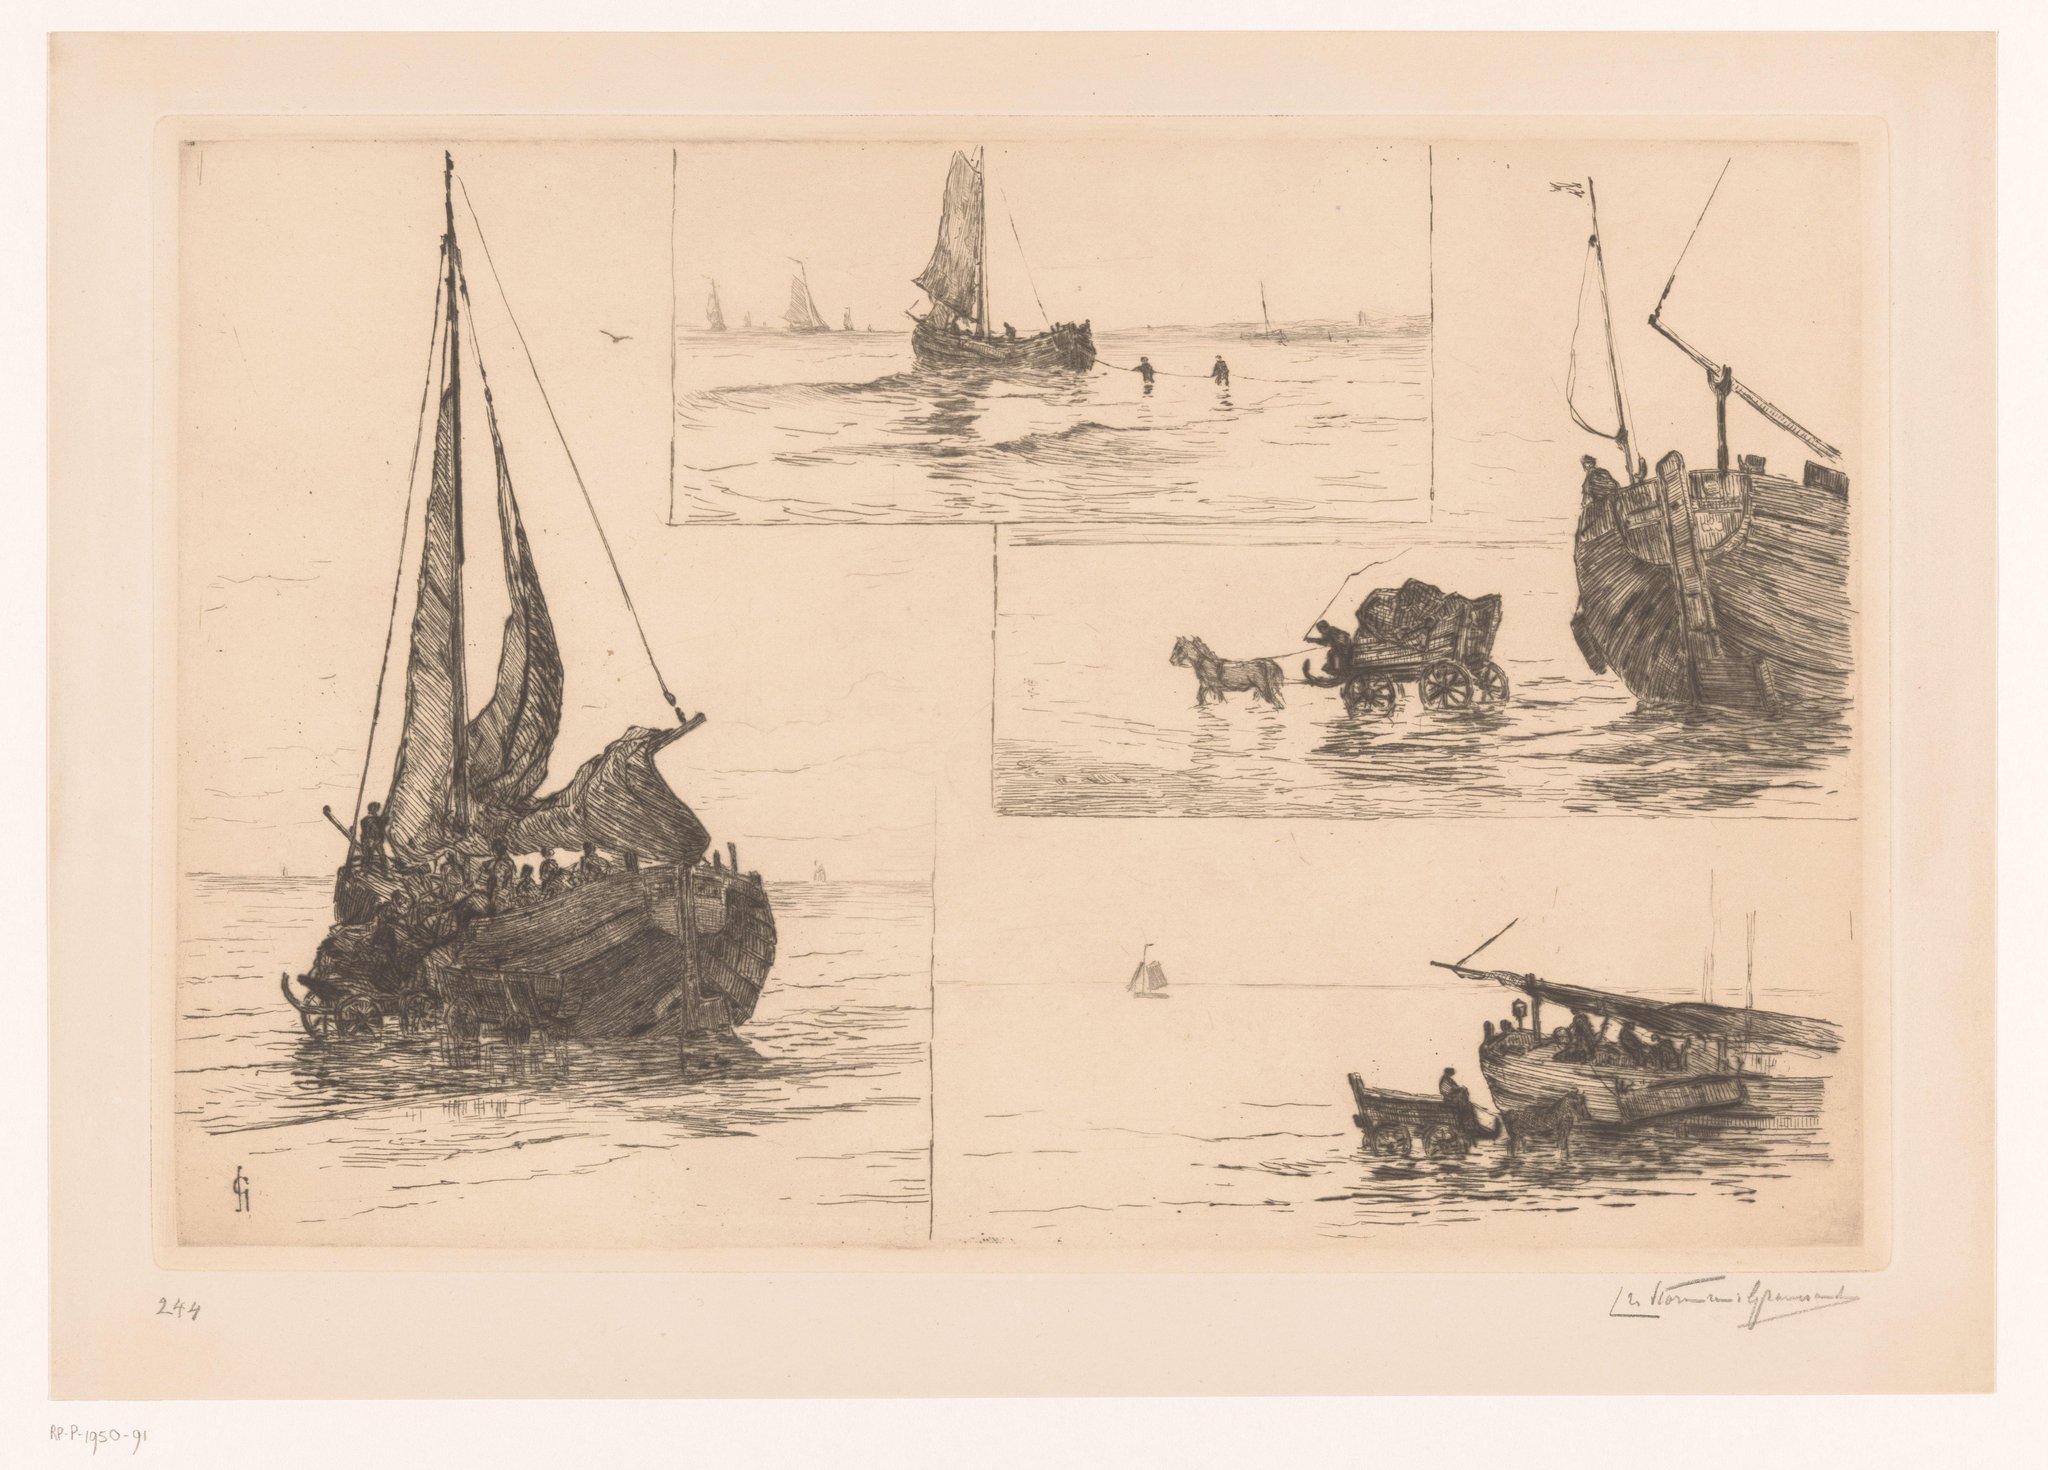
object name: print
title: Vier voorstellingen van schepen op het strand bij Katwijk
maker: carel nicolaas storm van s-gravesande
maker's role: draughtsman, print maker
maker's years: 1841-1924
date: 1887-1889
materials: paper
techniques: drypoint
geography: netherlands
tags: beach, ships, boats on land, beached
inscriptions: number: ‘244’, collector's mark: Lugt 2228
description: Mogelijk ook vermeld in: Storm van 's-Gravesande, Charles. Catalogue des eaux-fortes et lithographies. New York: s.n., 1903, of in een onbekende latere uitgave van het manuscript. Vermoedelijk vermeld als catalogusnummer 244.